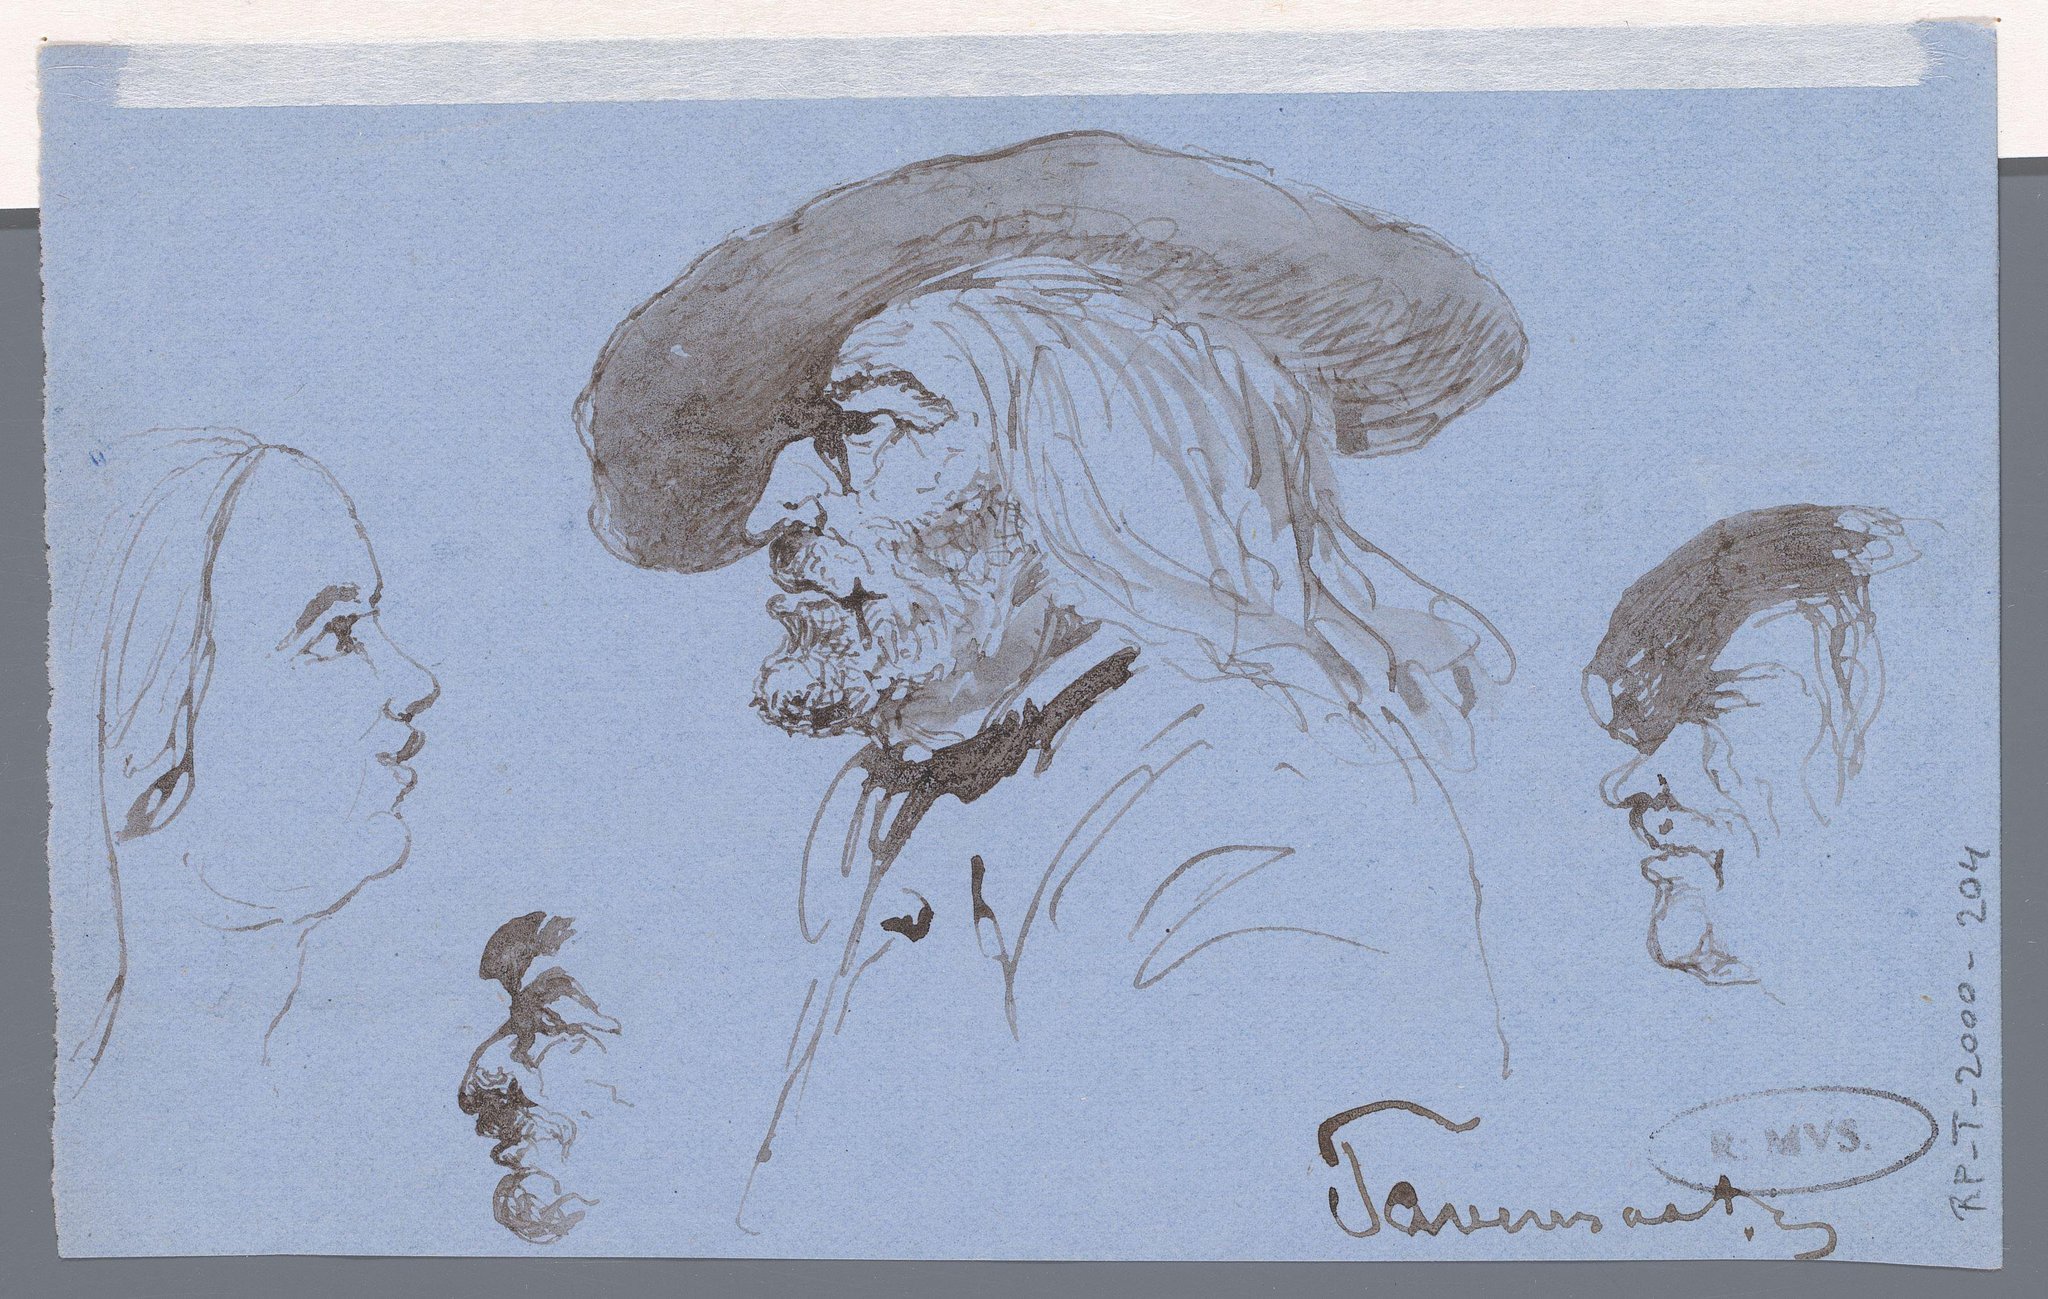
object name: drawing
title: Koppen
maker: johannes tavenraat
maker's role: draughtsman, painter, print maker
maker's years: 1809-1881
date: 1840-1880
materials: ink, paper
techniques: brush, pen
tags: caricatures (human types)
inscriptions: collector's mark: Lugt 2228, signature: ‘Tavenraat’